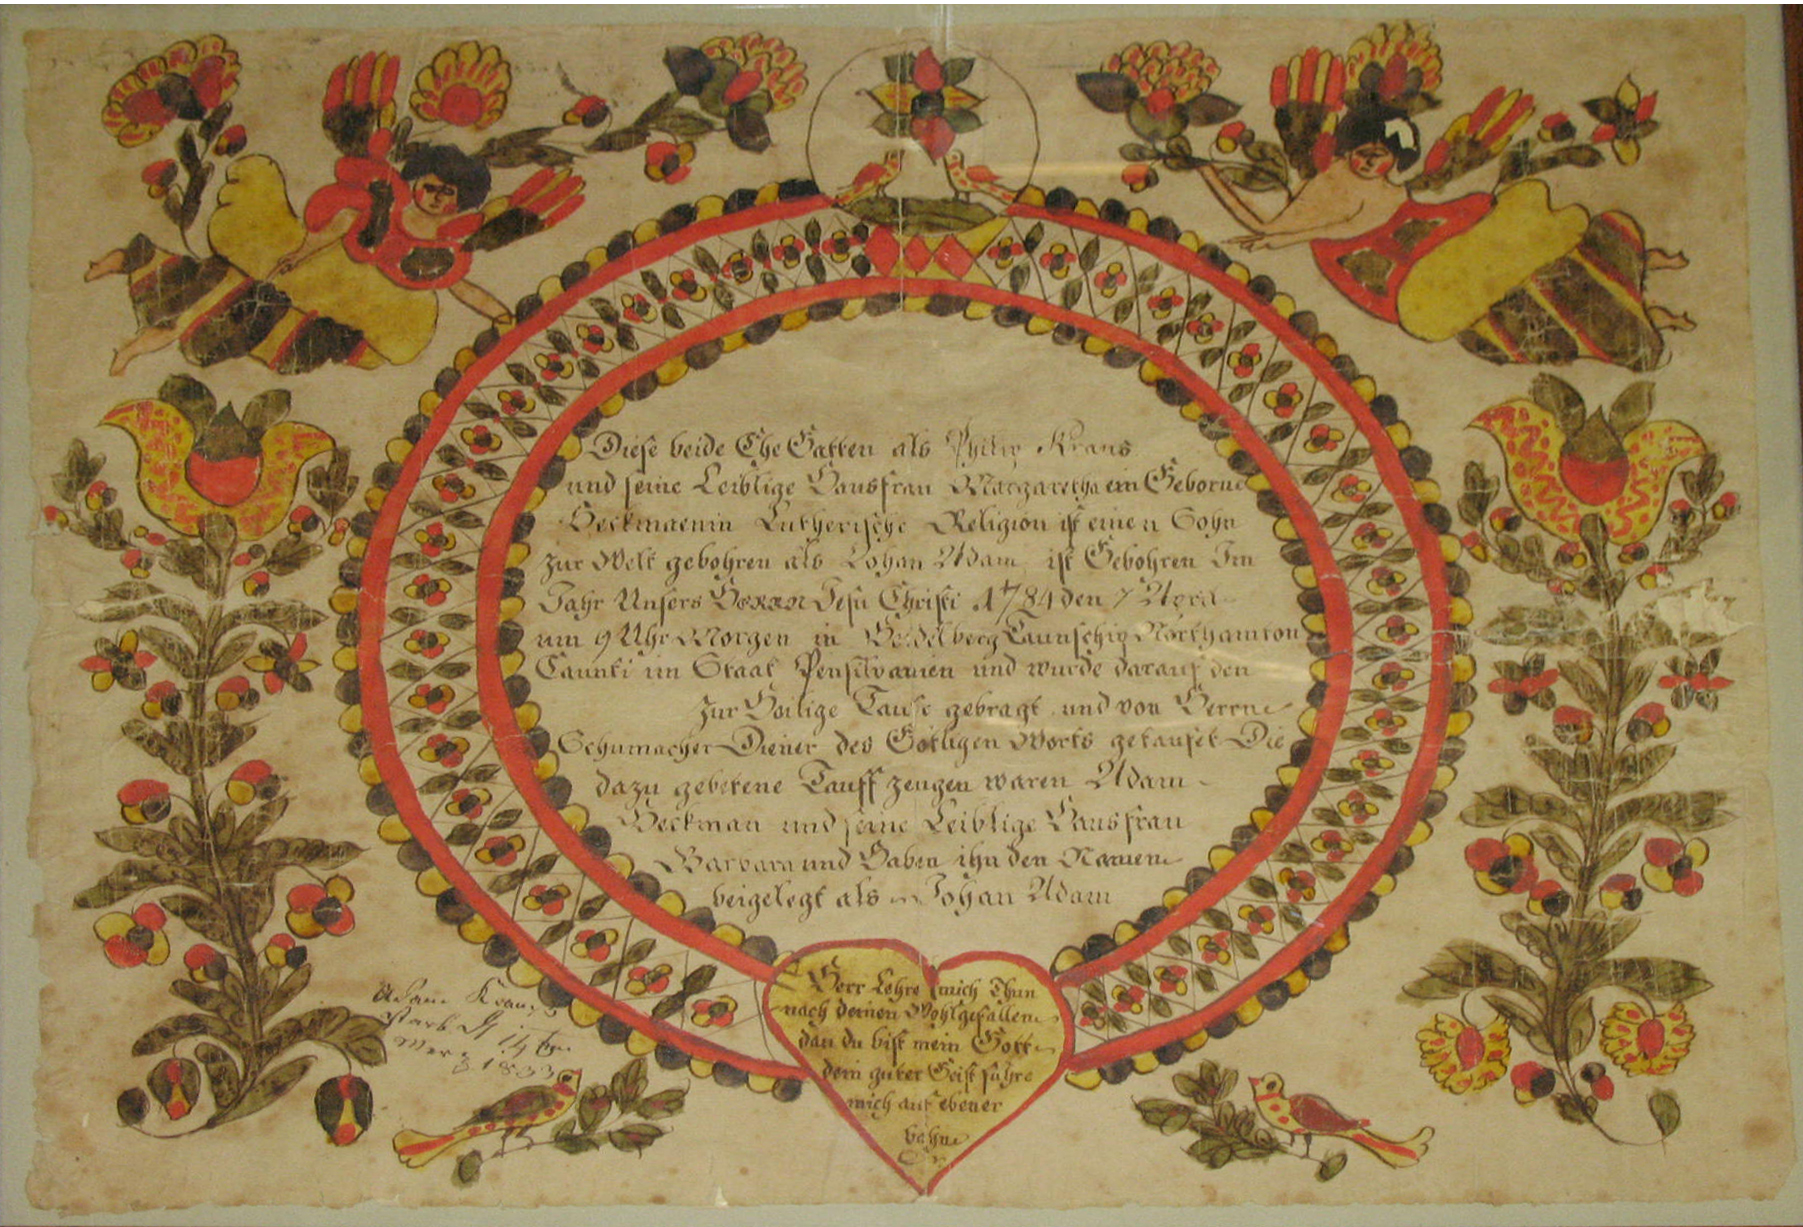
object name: birth and baptismal certificate, fraktur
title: Birth and Baptismal Certificate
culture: american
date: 1784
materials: ink, paper, watercolor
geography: united states